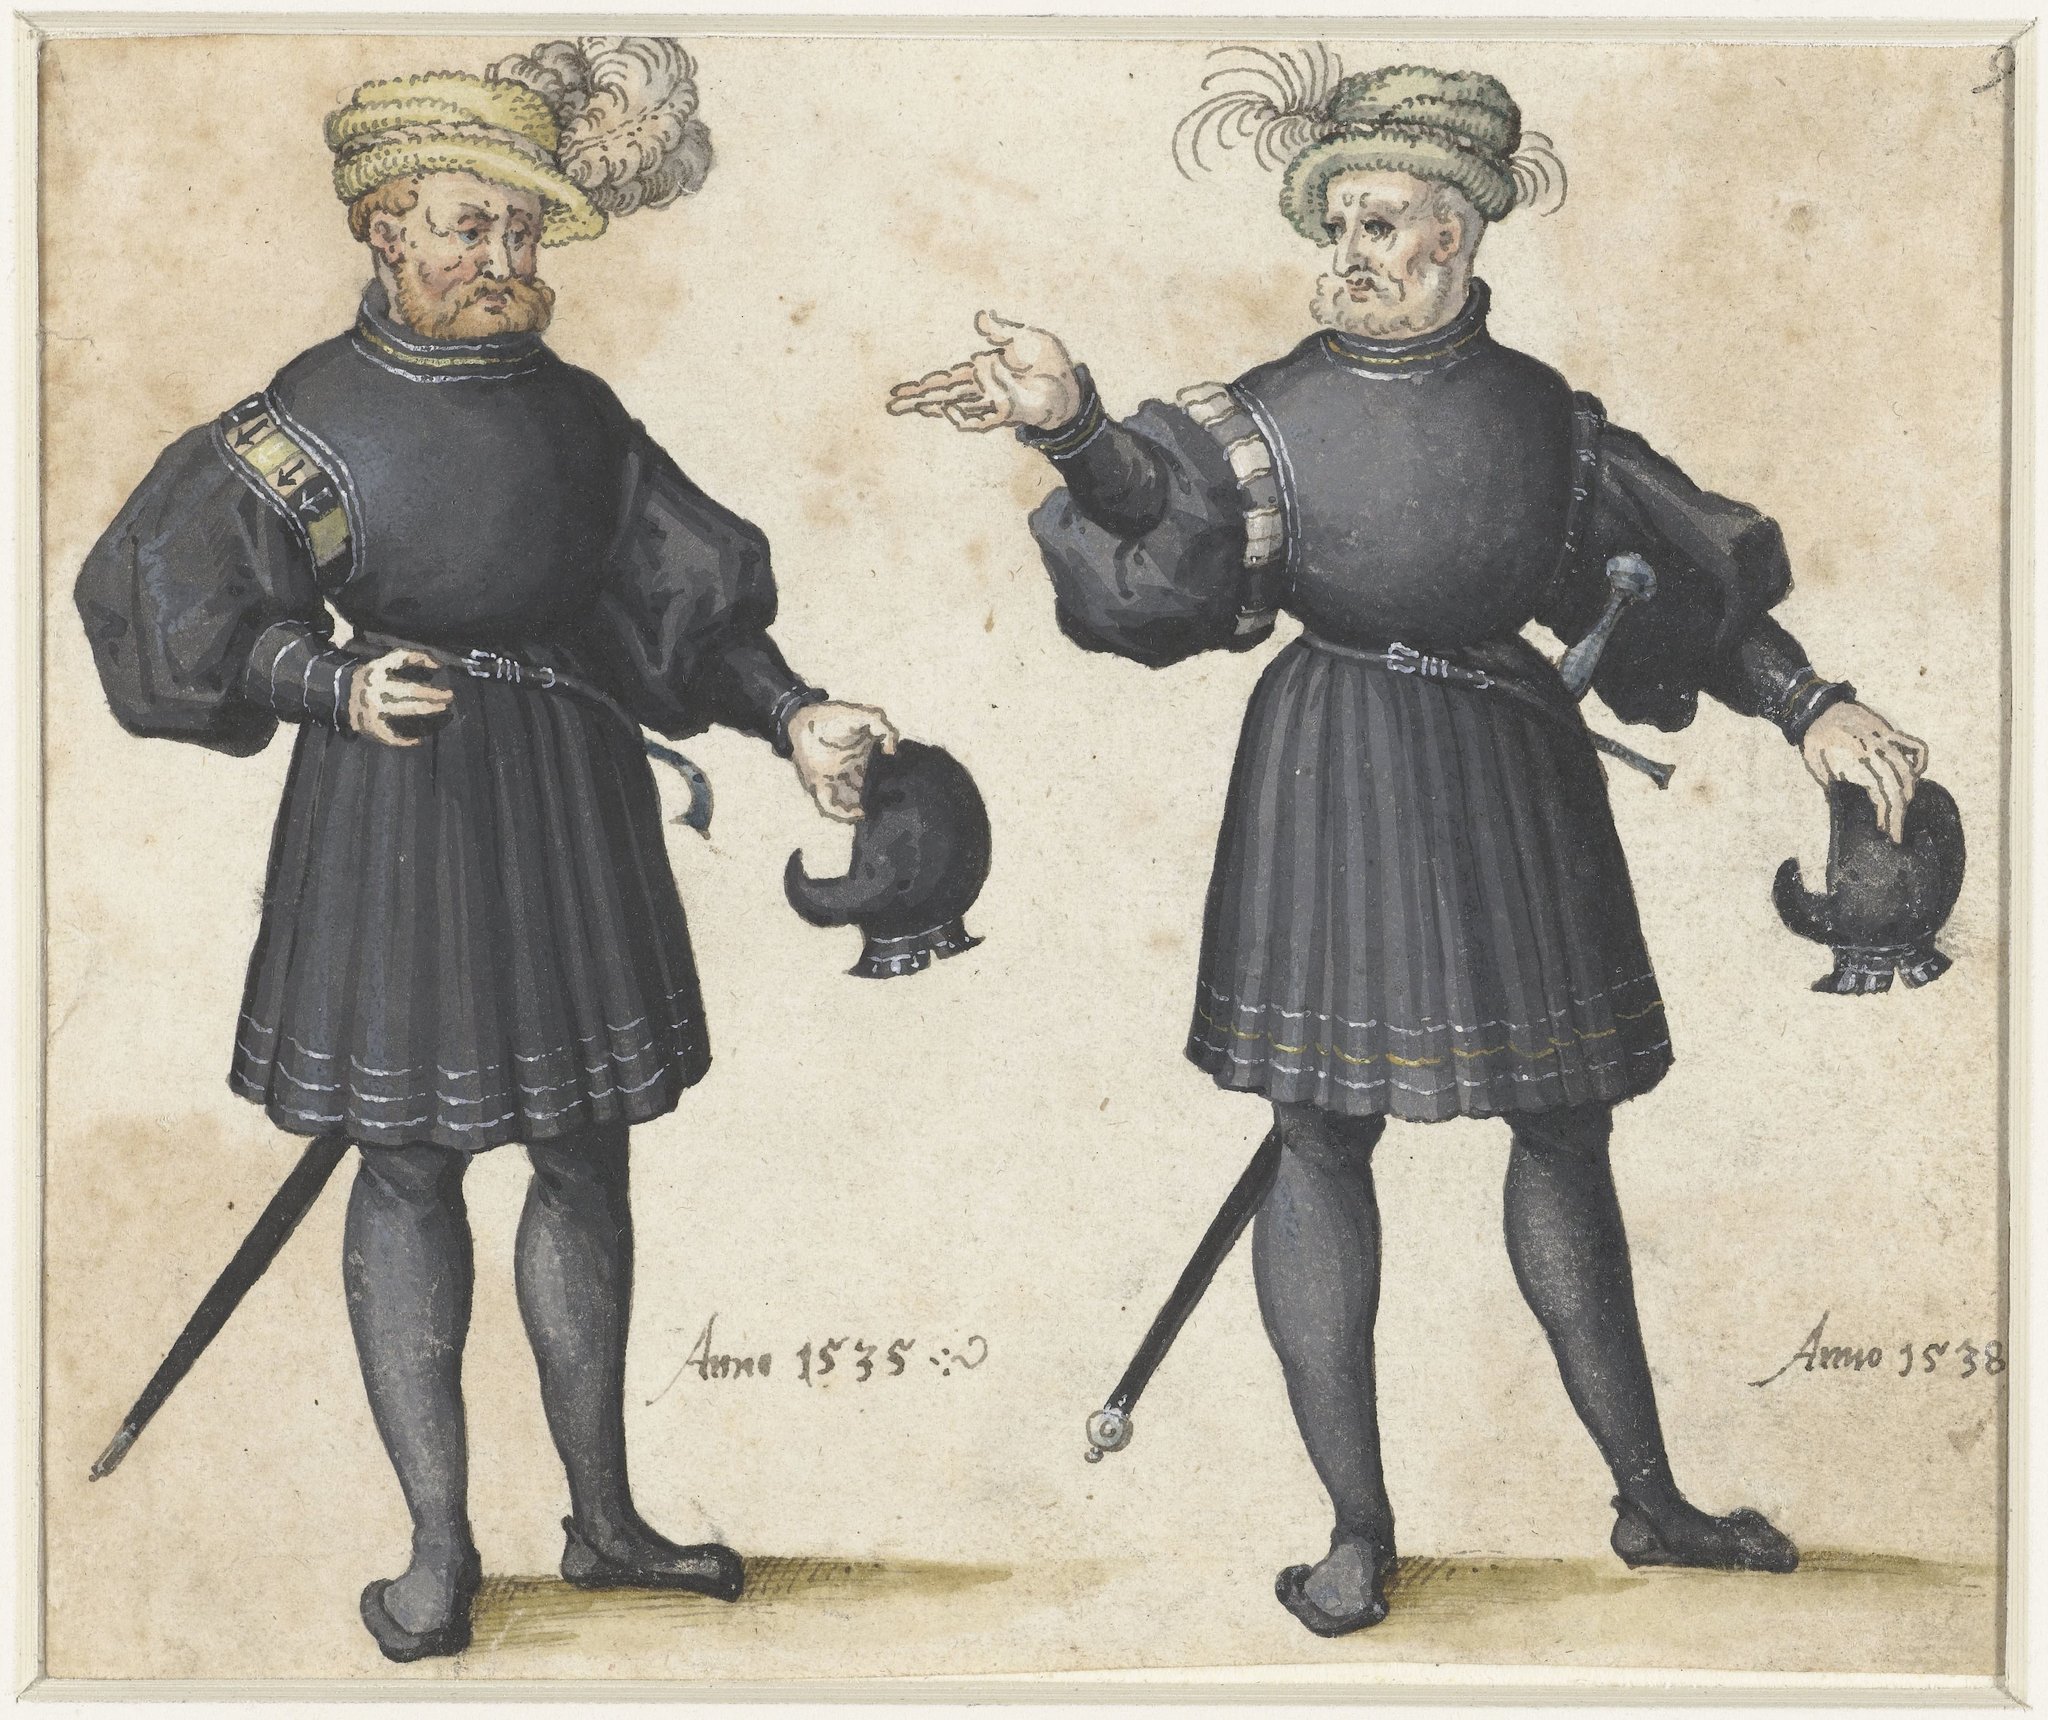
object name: drawing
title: Twee hofdienaren in zwarte kleding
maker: Anonymous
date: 1530-1560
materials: ink, paper, watercolor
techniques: brush, pen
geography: southern germany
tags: royal household; courtiers, retinue, train